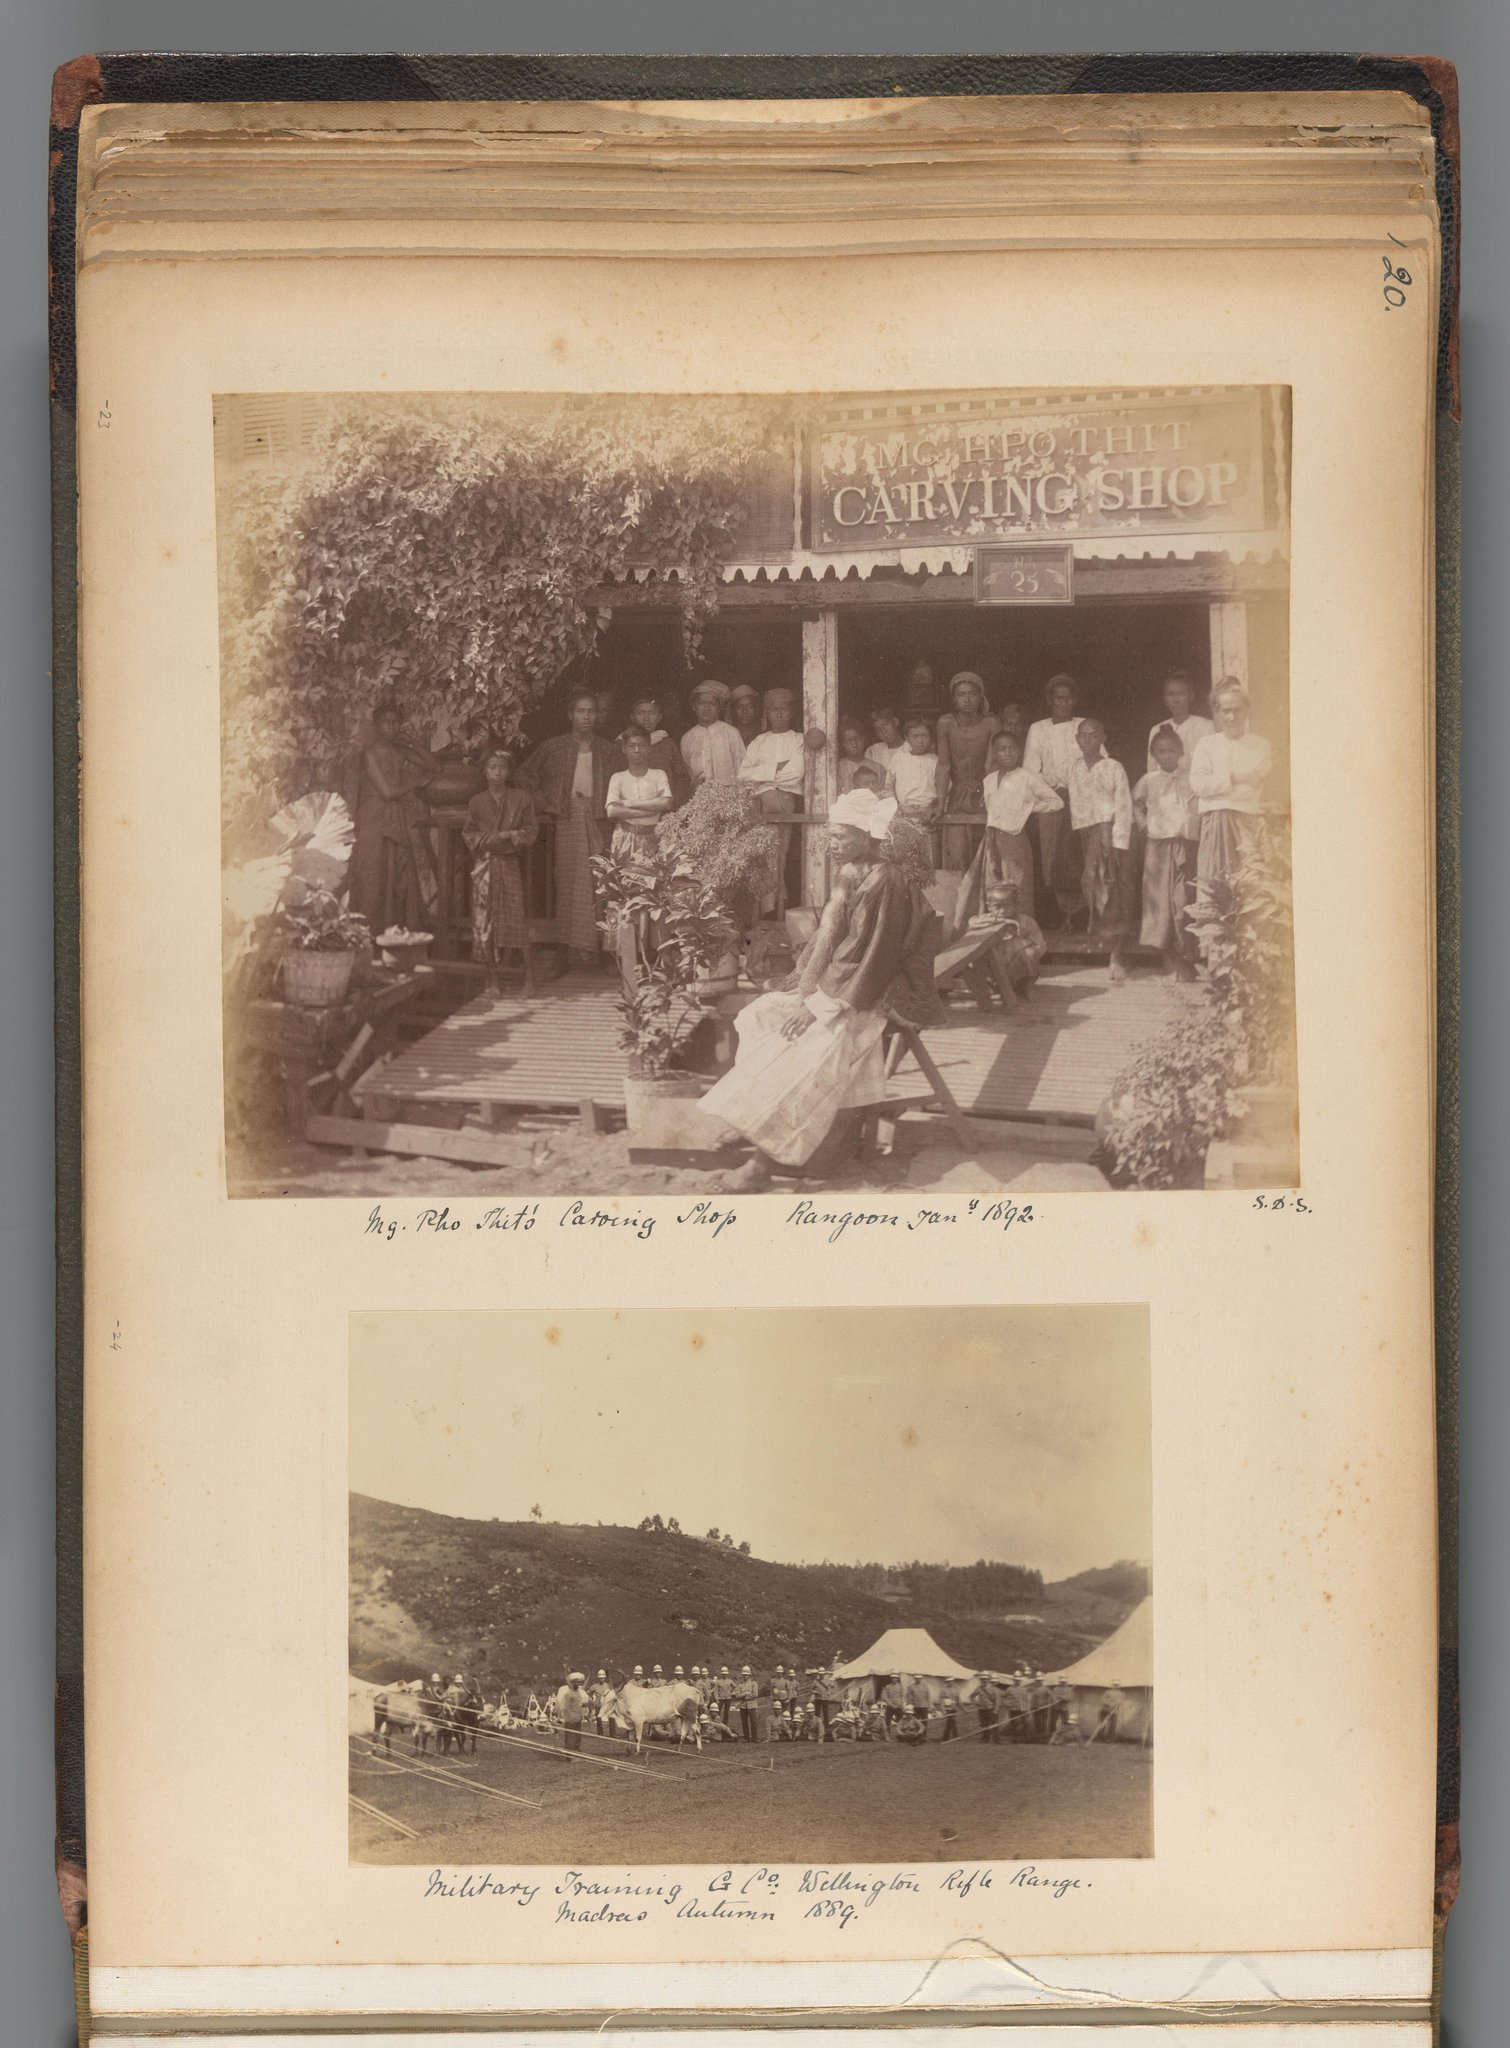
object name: photograph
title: Myanmarese mensen voor een houtsnijderij in Yangon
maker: c.c. blackburn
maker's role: fotograaf, luitenant-kolonel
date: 1801-1892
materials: paper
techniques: albumen print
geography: yangon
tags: shop, store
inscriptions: number: ‘S.D.S.’